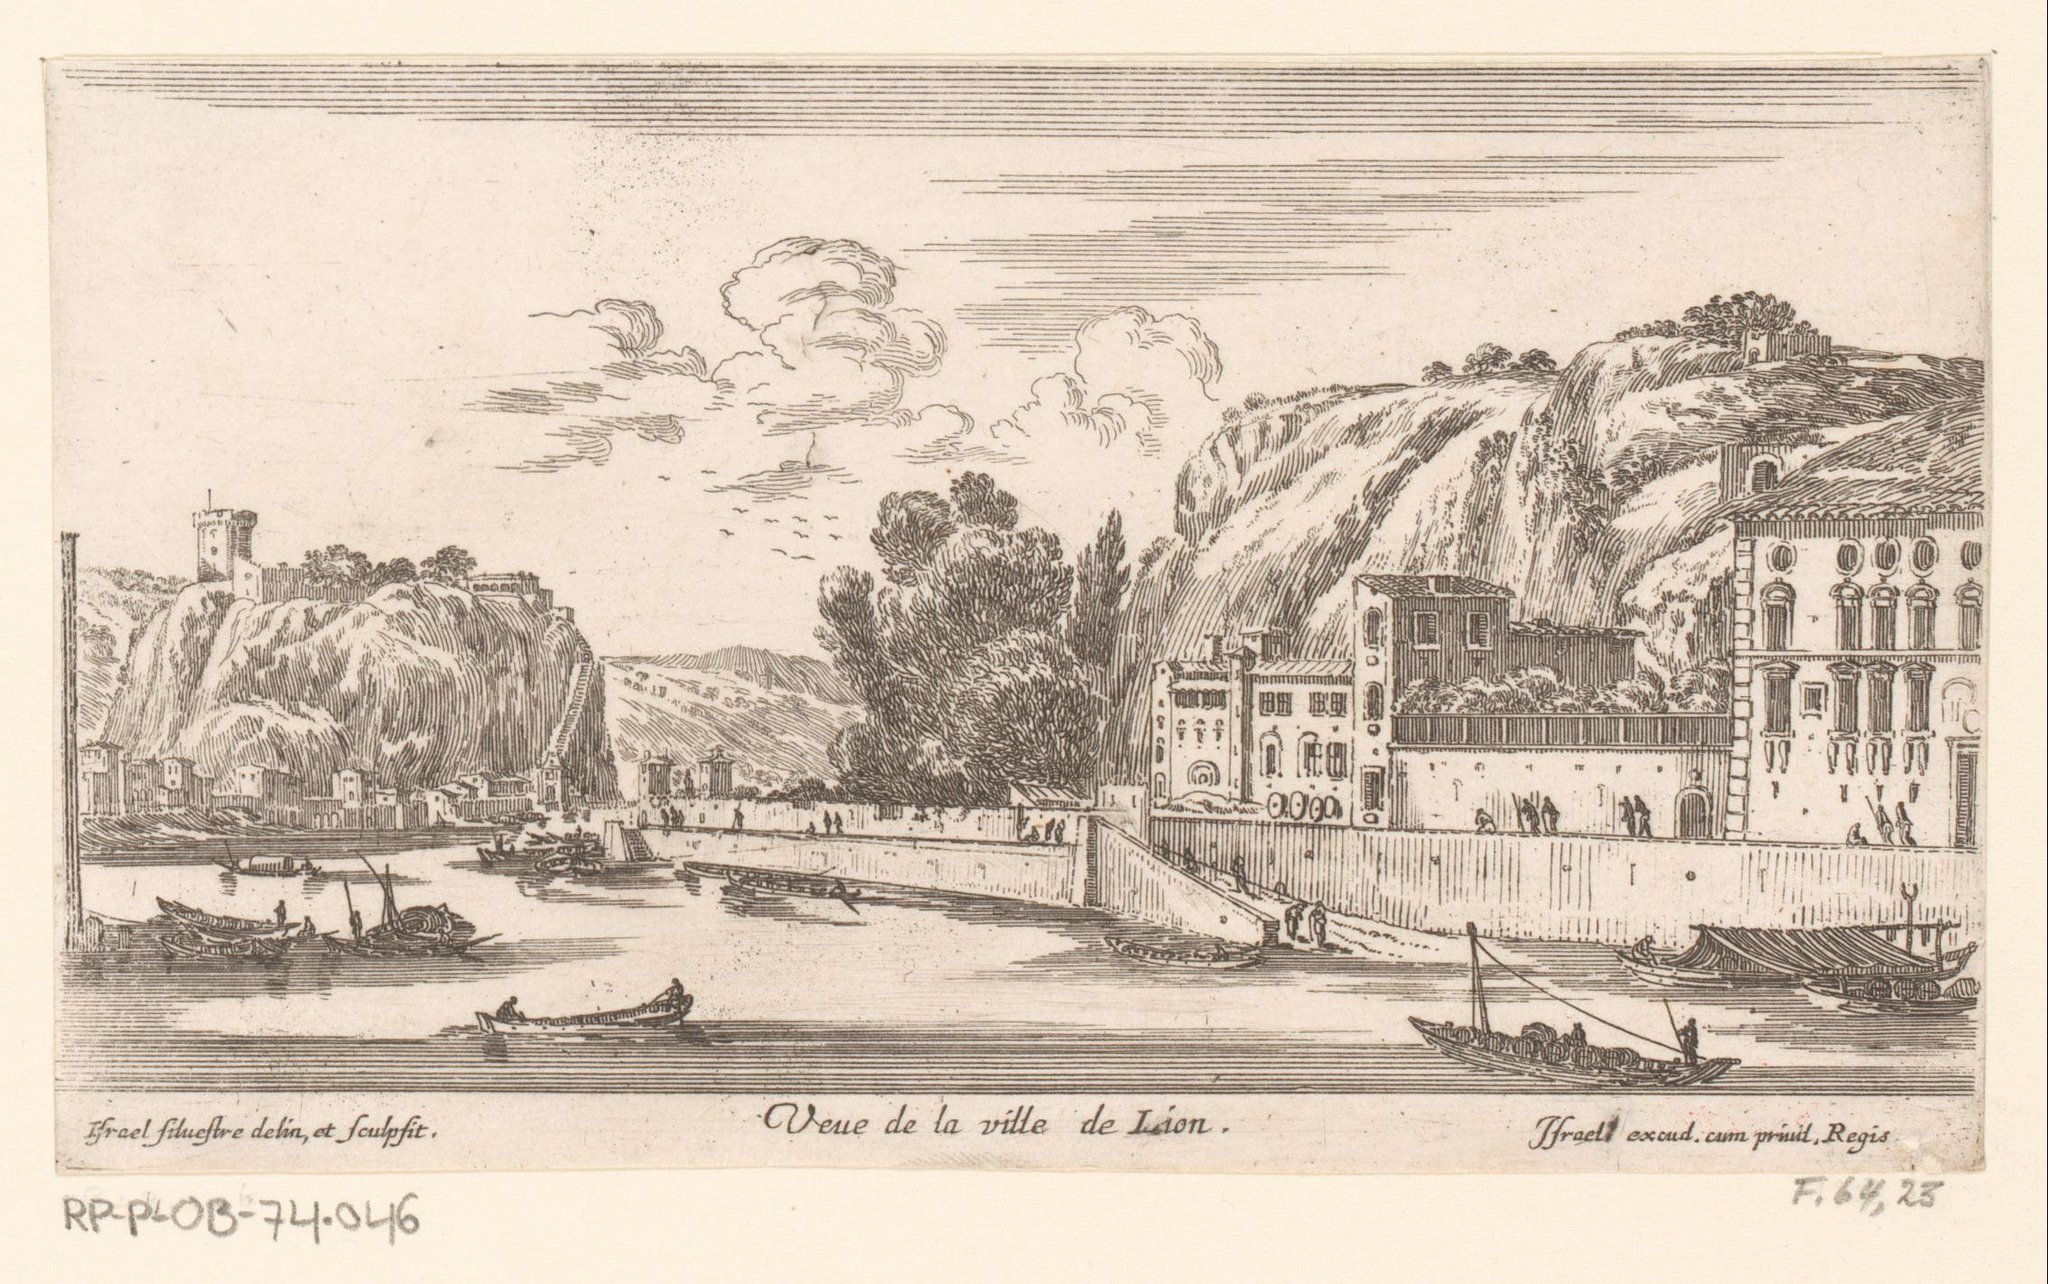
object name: print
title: Diverses Veues faictes par Israel Silvestre 1652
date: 1652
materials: paper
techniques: engraving, etching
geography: france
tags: city-view, and landscape with man-made constructions (+ city(-scape) with figures, staffage), lyon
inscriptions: collector's mark: Lugt 240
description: Prent maakt deel uit van een ongenummerde serie van 30 prenten.